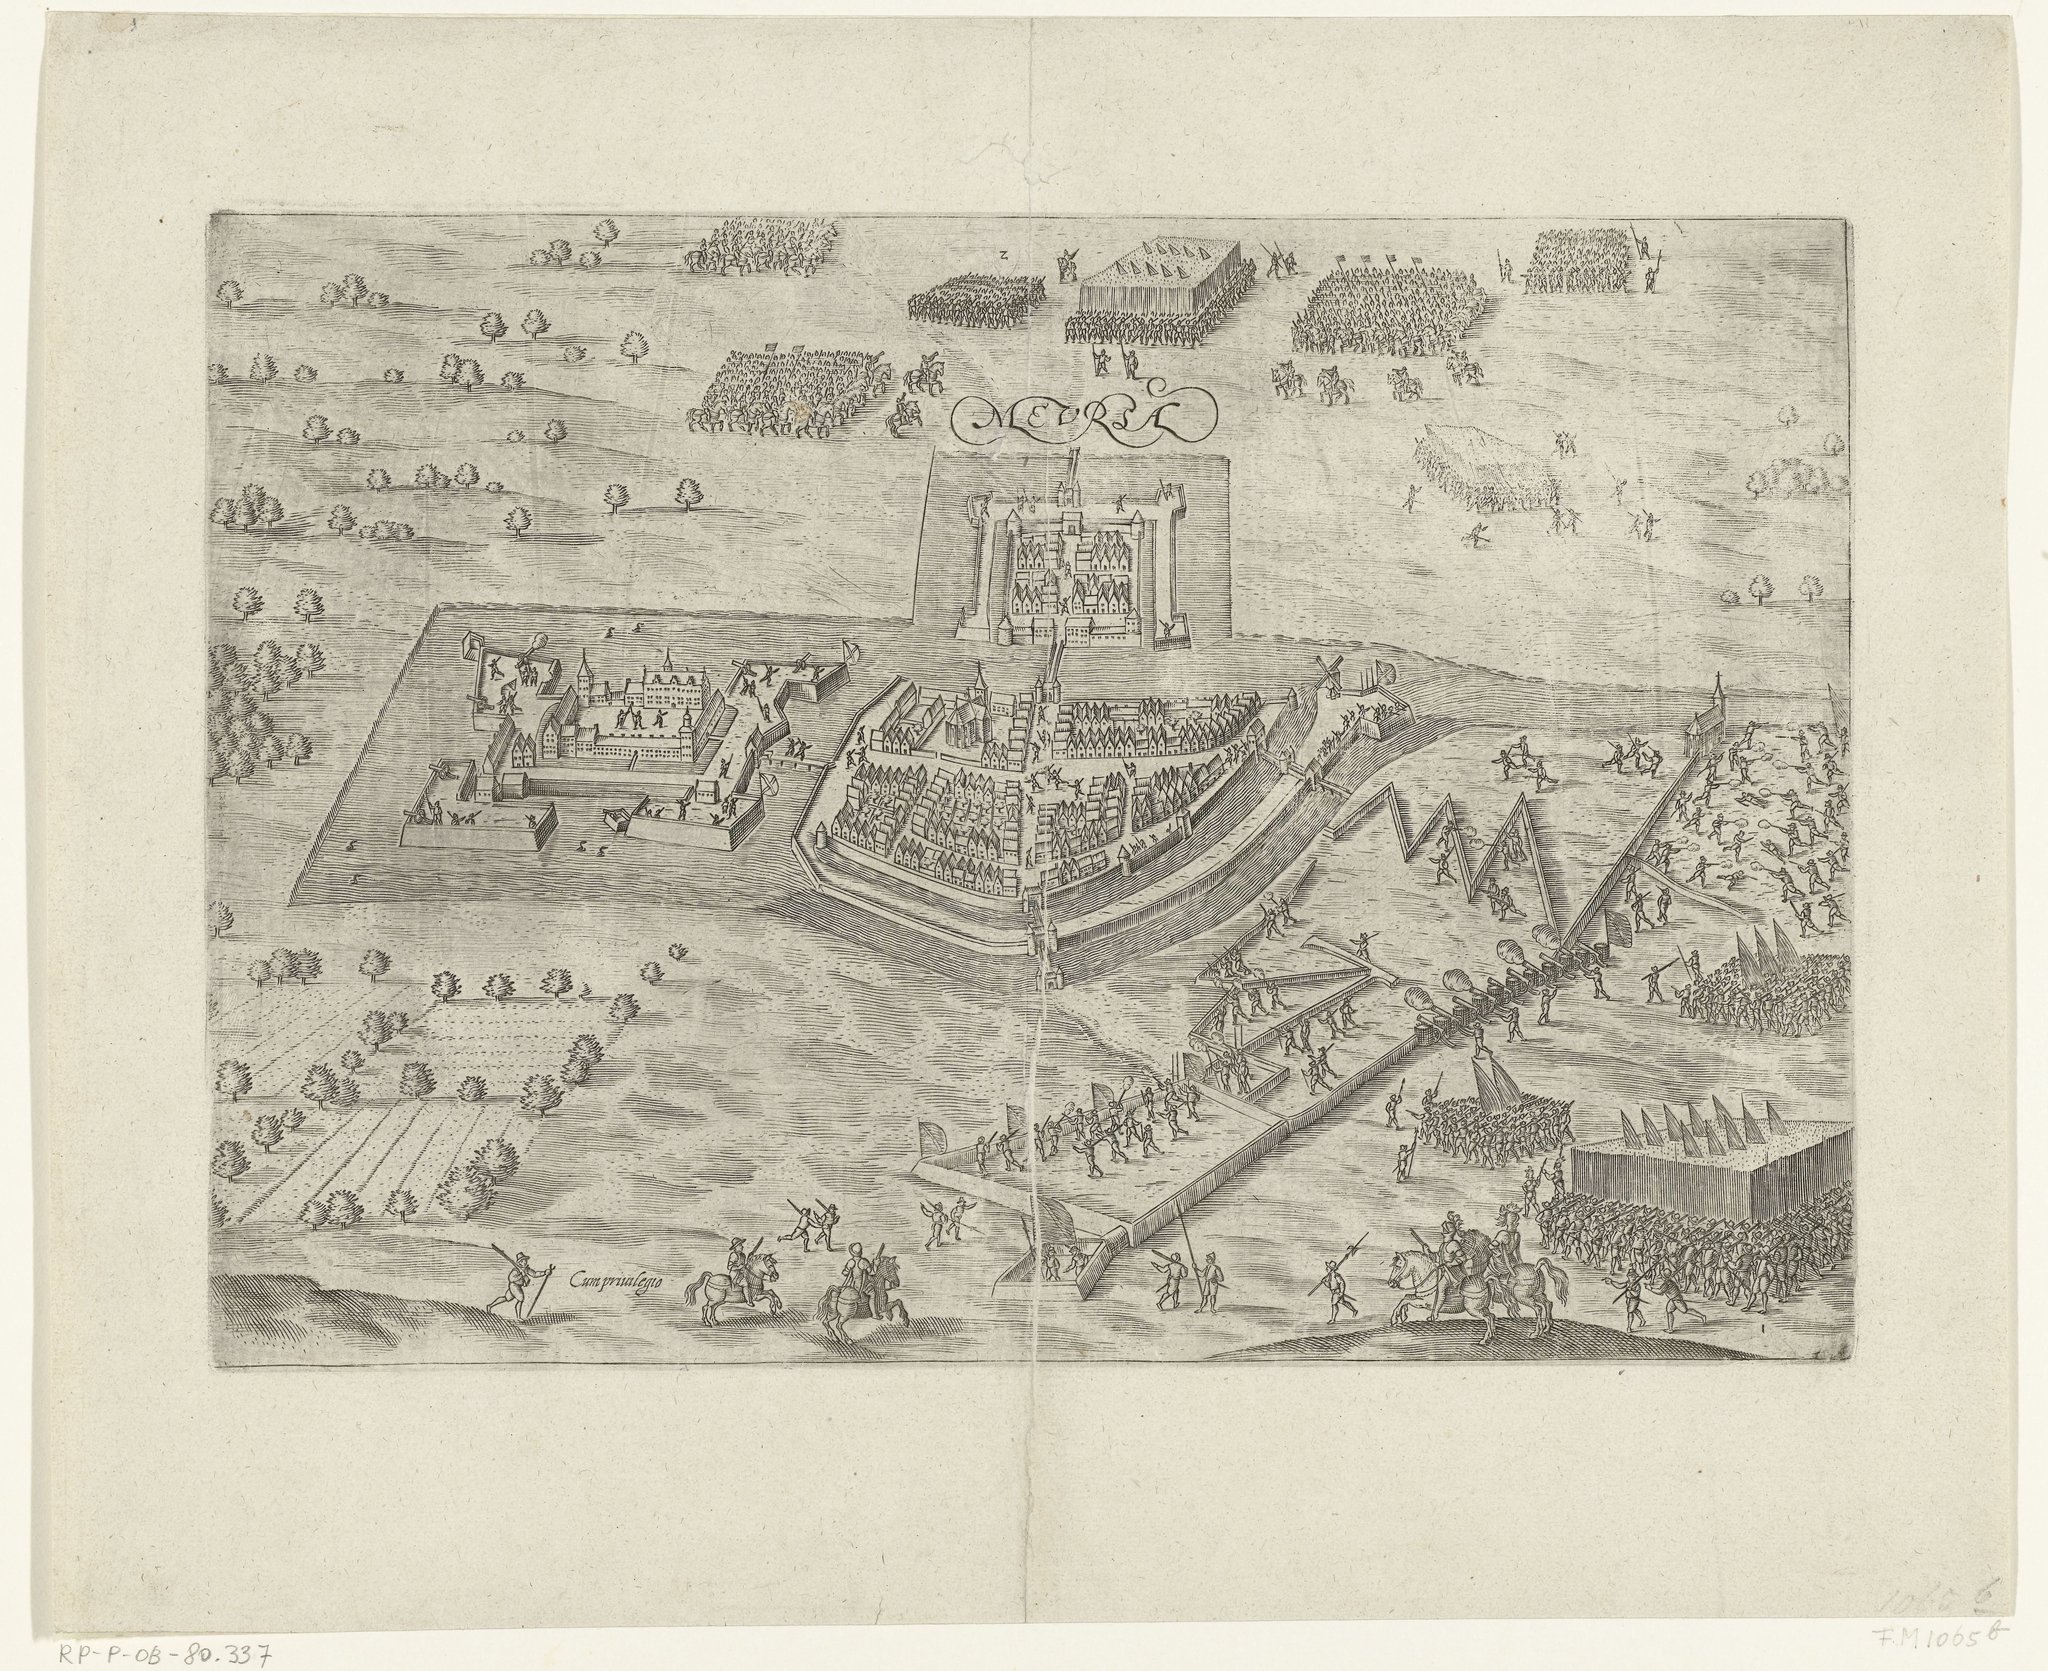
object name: print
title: Beleg en verovering van Meurs, 1597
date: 1600-1601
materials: paper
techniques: engraving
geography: northern netherlands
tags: the hague, maurice (prince of orange), siege, position war, capture of city (after the siege)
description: In deze staat maar dan met onderschrift gebruikt als illustratie in: J.J. Orlers, Den Nassauschen Lauren-Crans: Beschrijvinghe ende af-beeldinge van alle de victorien ... die Godt Almachtich de ... Staten der Vereenichde Nederlanden verleent heeft, deur het wijs ende clouck beleyt des Hooch-ghebooren Fursts Maurits van Nassau, J.J. Orlers en H. van Haestens, Leiden 1610, fol. 120/121. Deze staat niet vermeld in Frederik Muller.